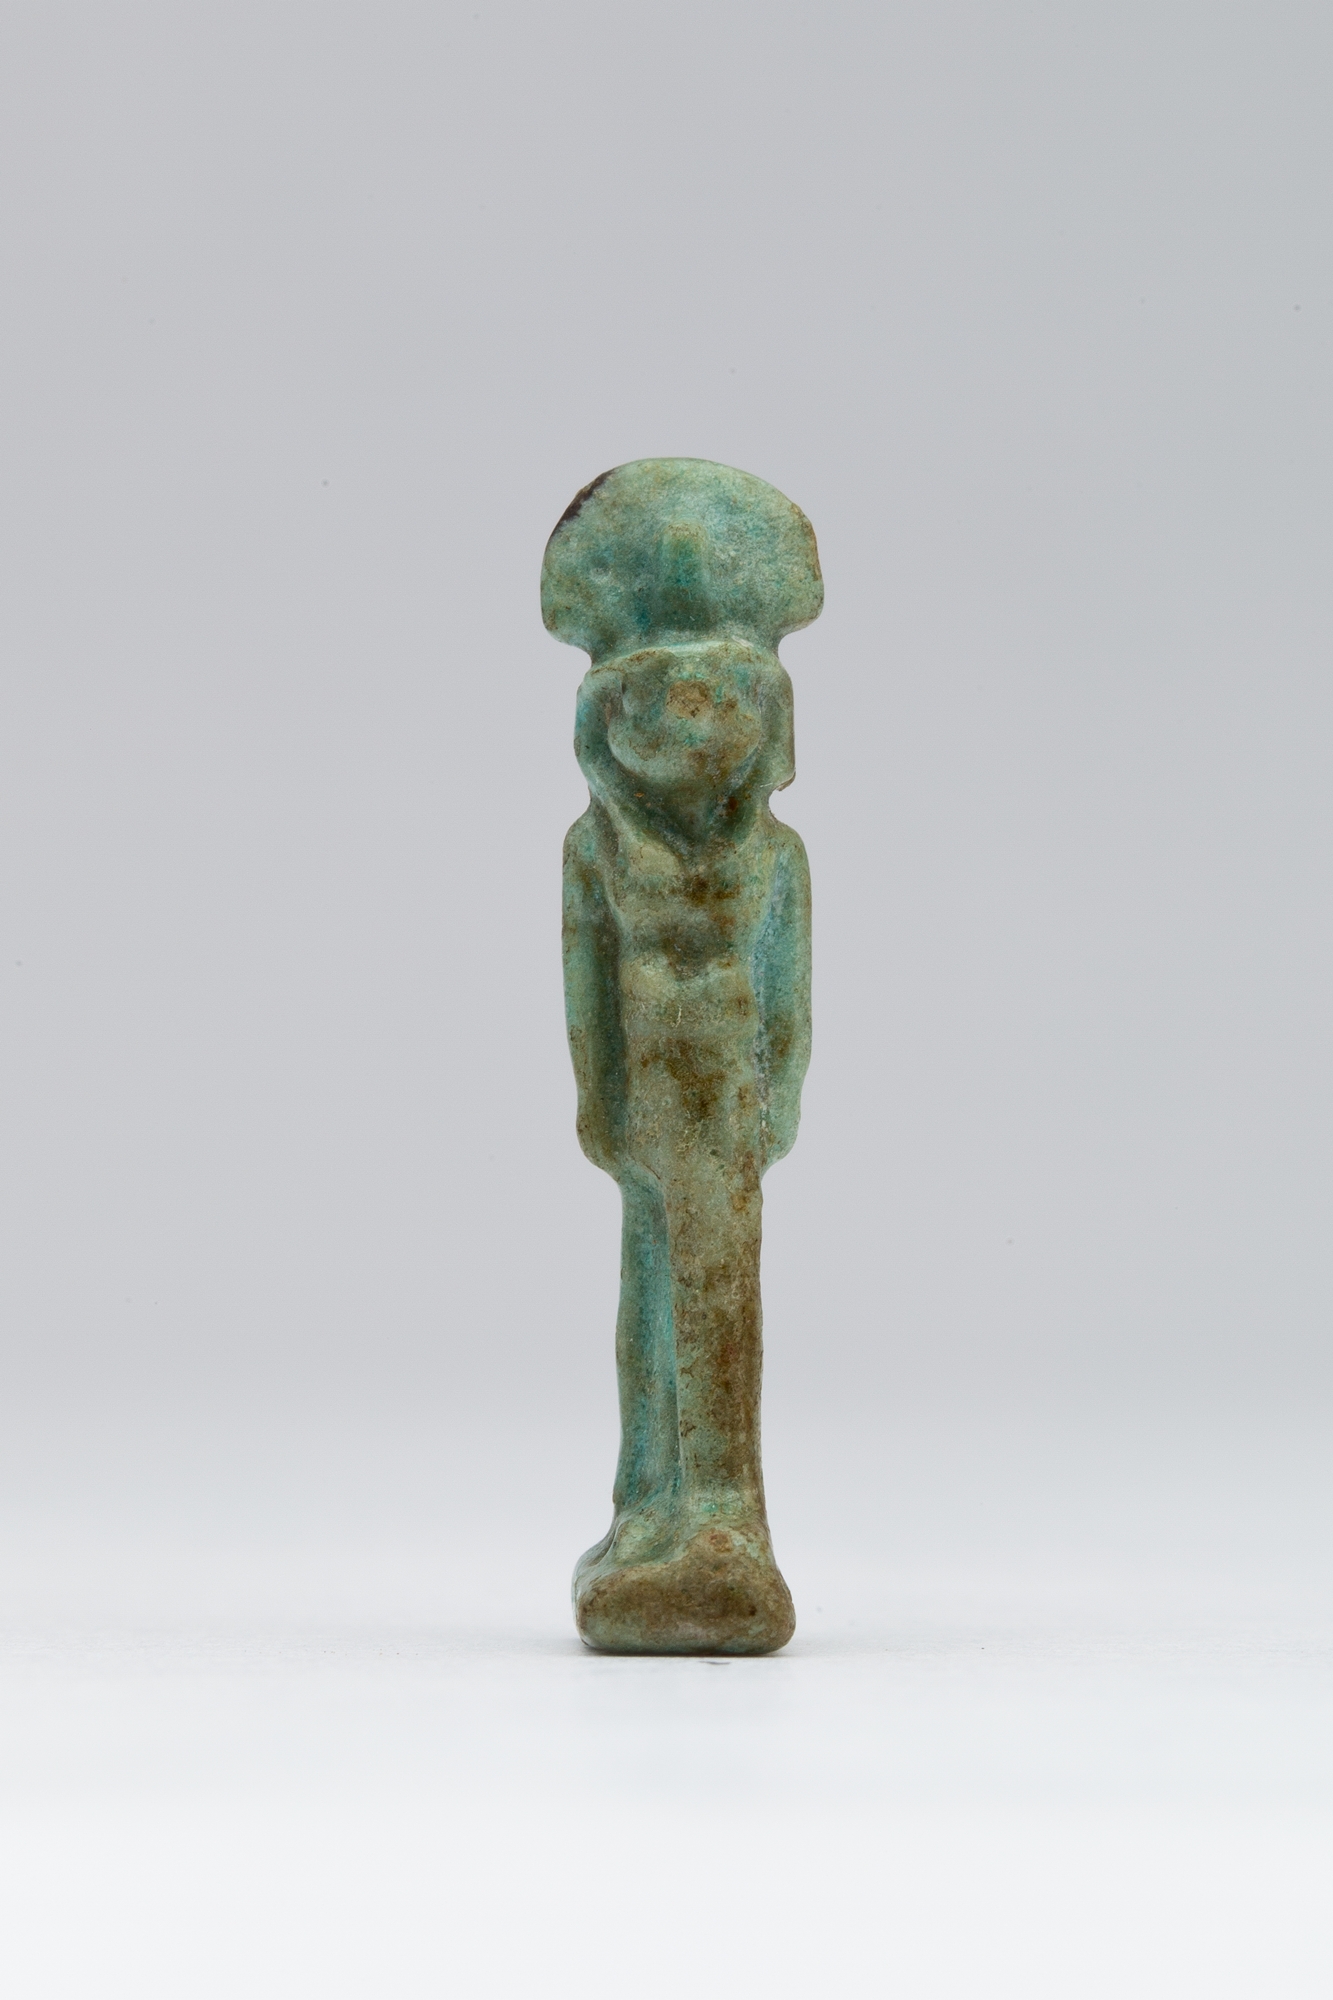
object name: amulet, re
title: Re Amulet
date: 664-332 BCE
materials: faience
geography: egypt